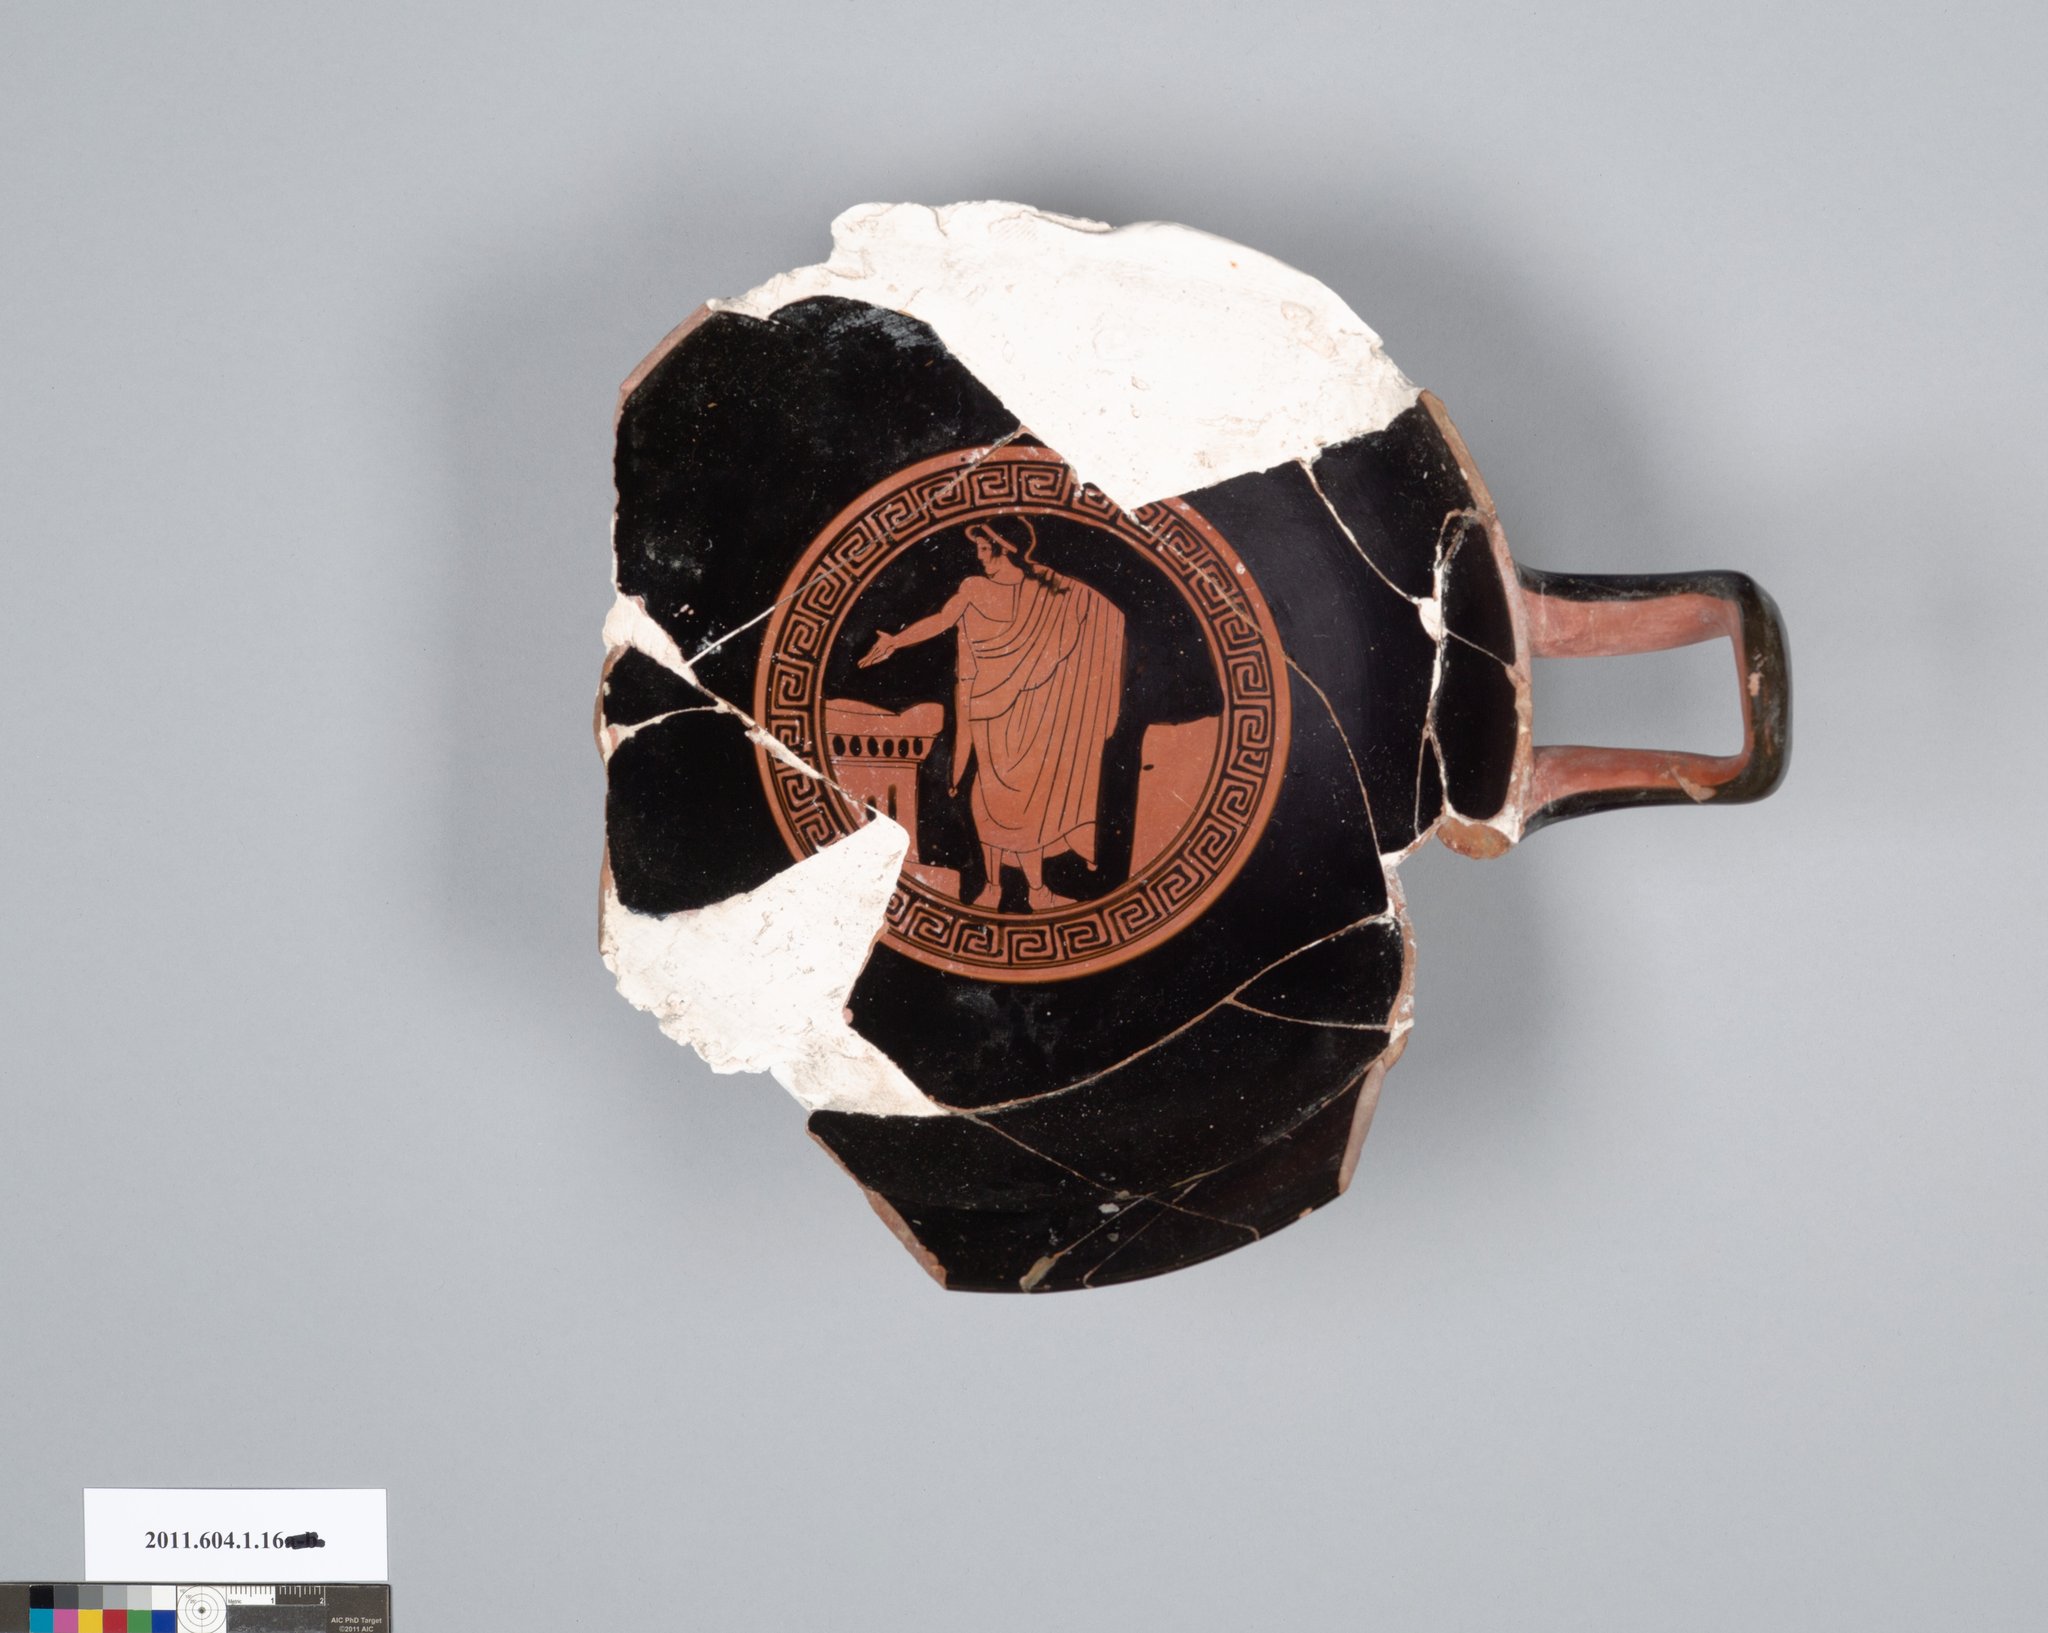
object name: kylix fragment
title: Terracotta fragments of a kylix (drinking cup)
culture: greek, attic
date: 475-451 BCE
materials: terracotta